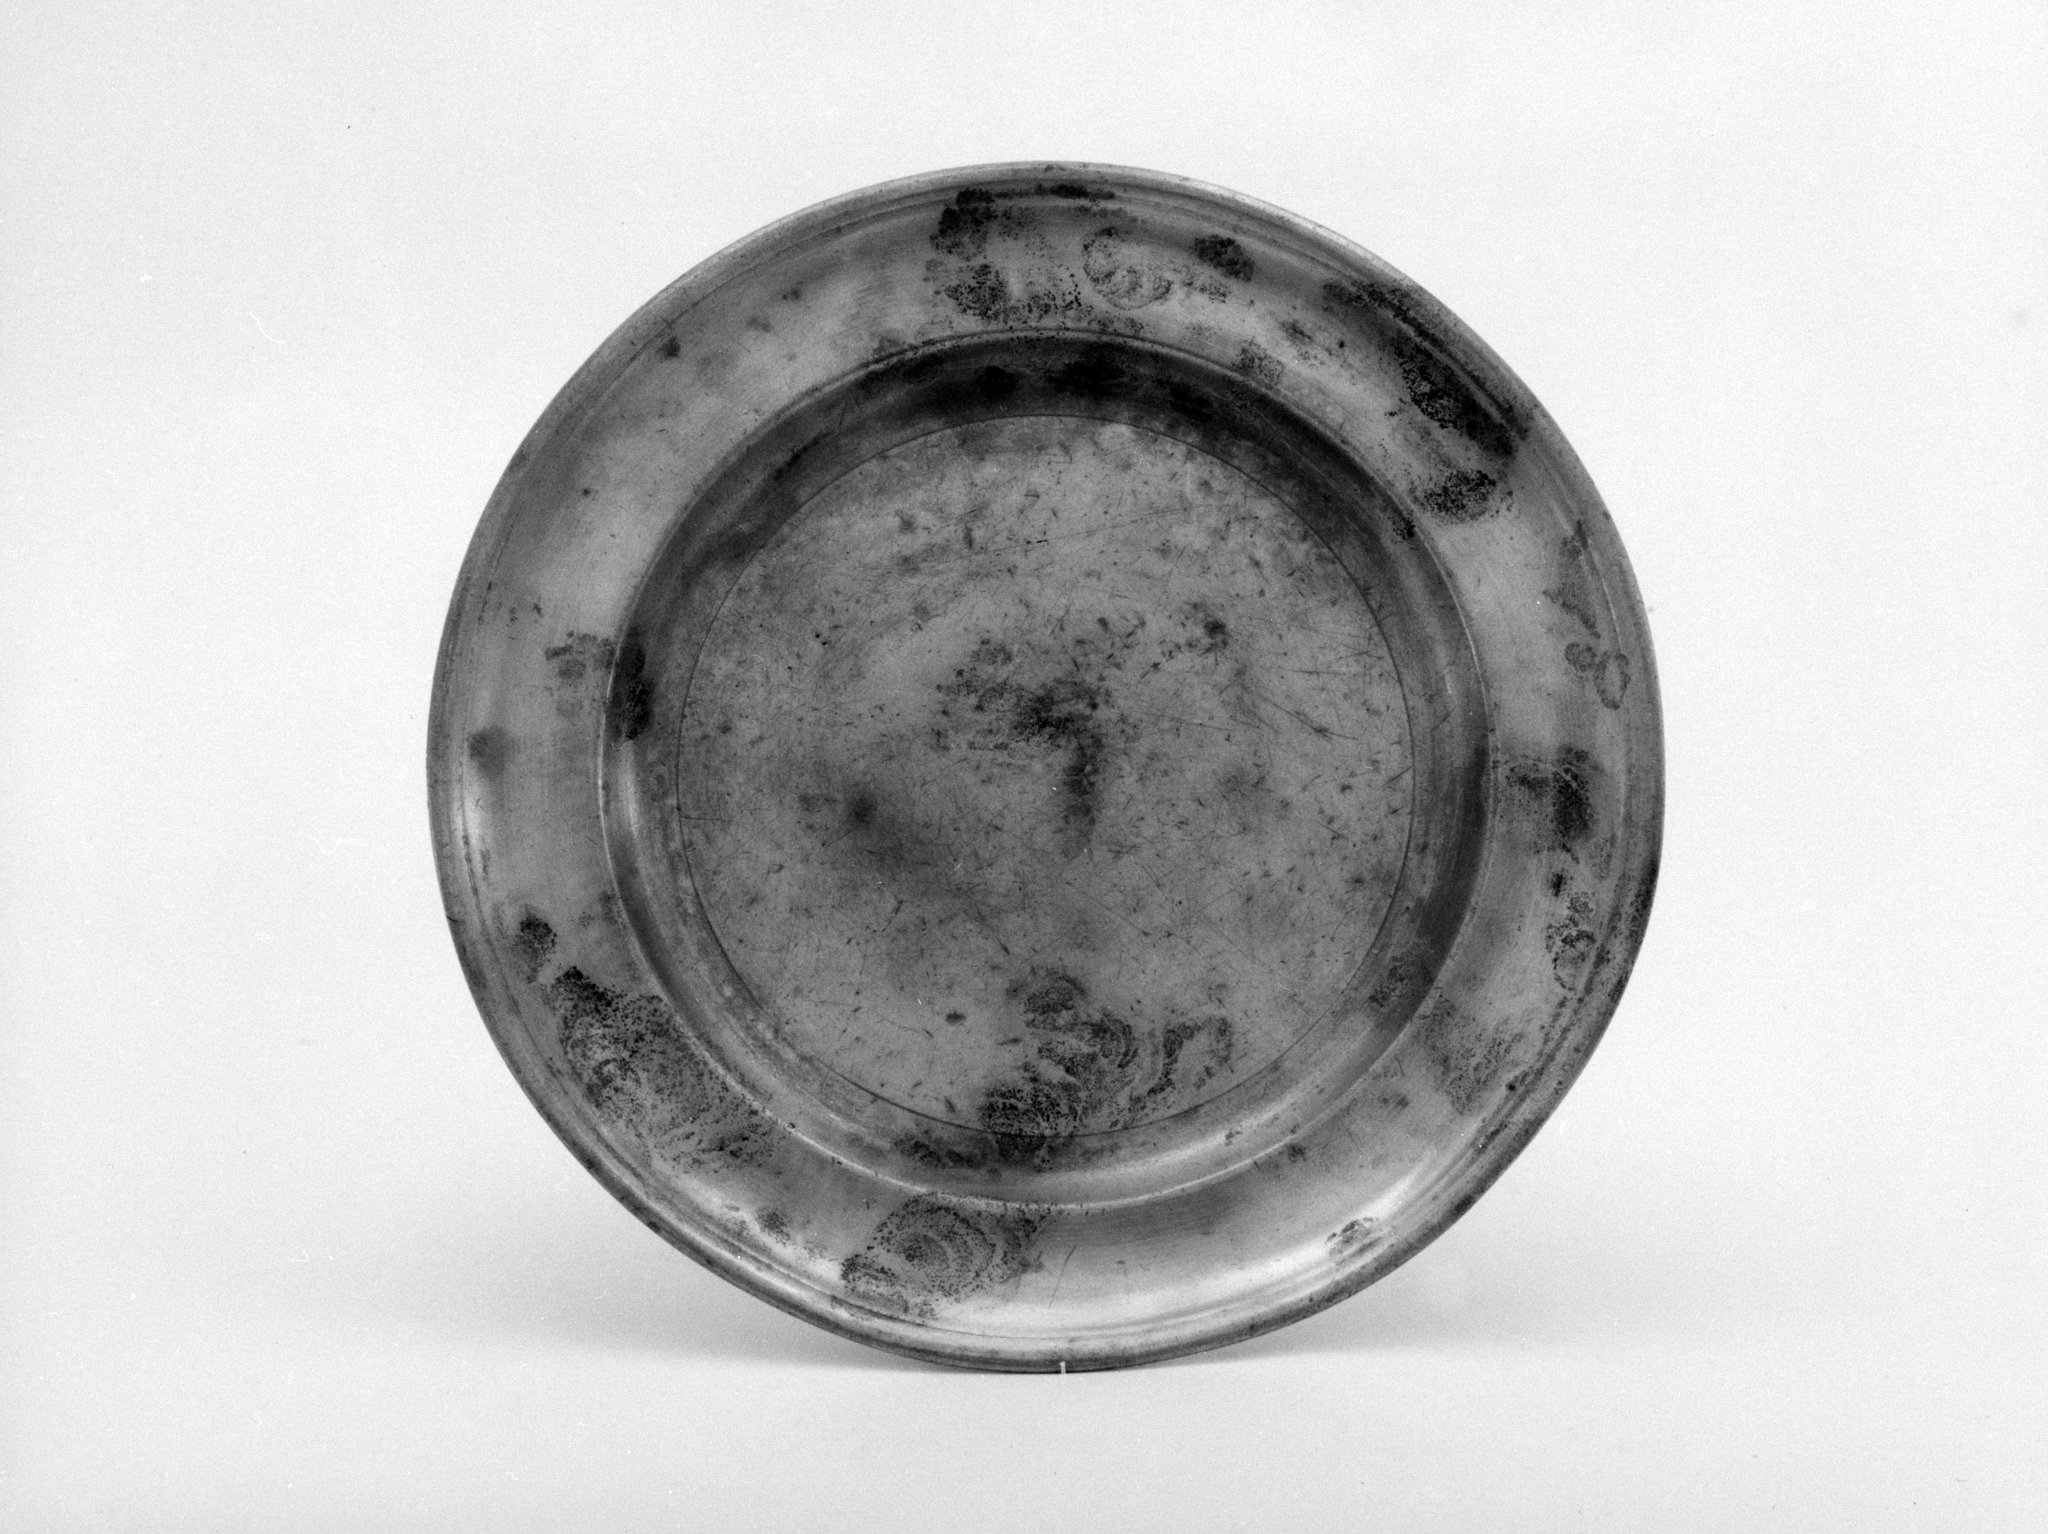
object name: plate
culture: american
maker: samuel kilbourn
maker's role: maker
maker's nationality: american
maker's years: 1793-1839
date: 1814-1839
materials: pewter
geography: united states